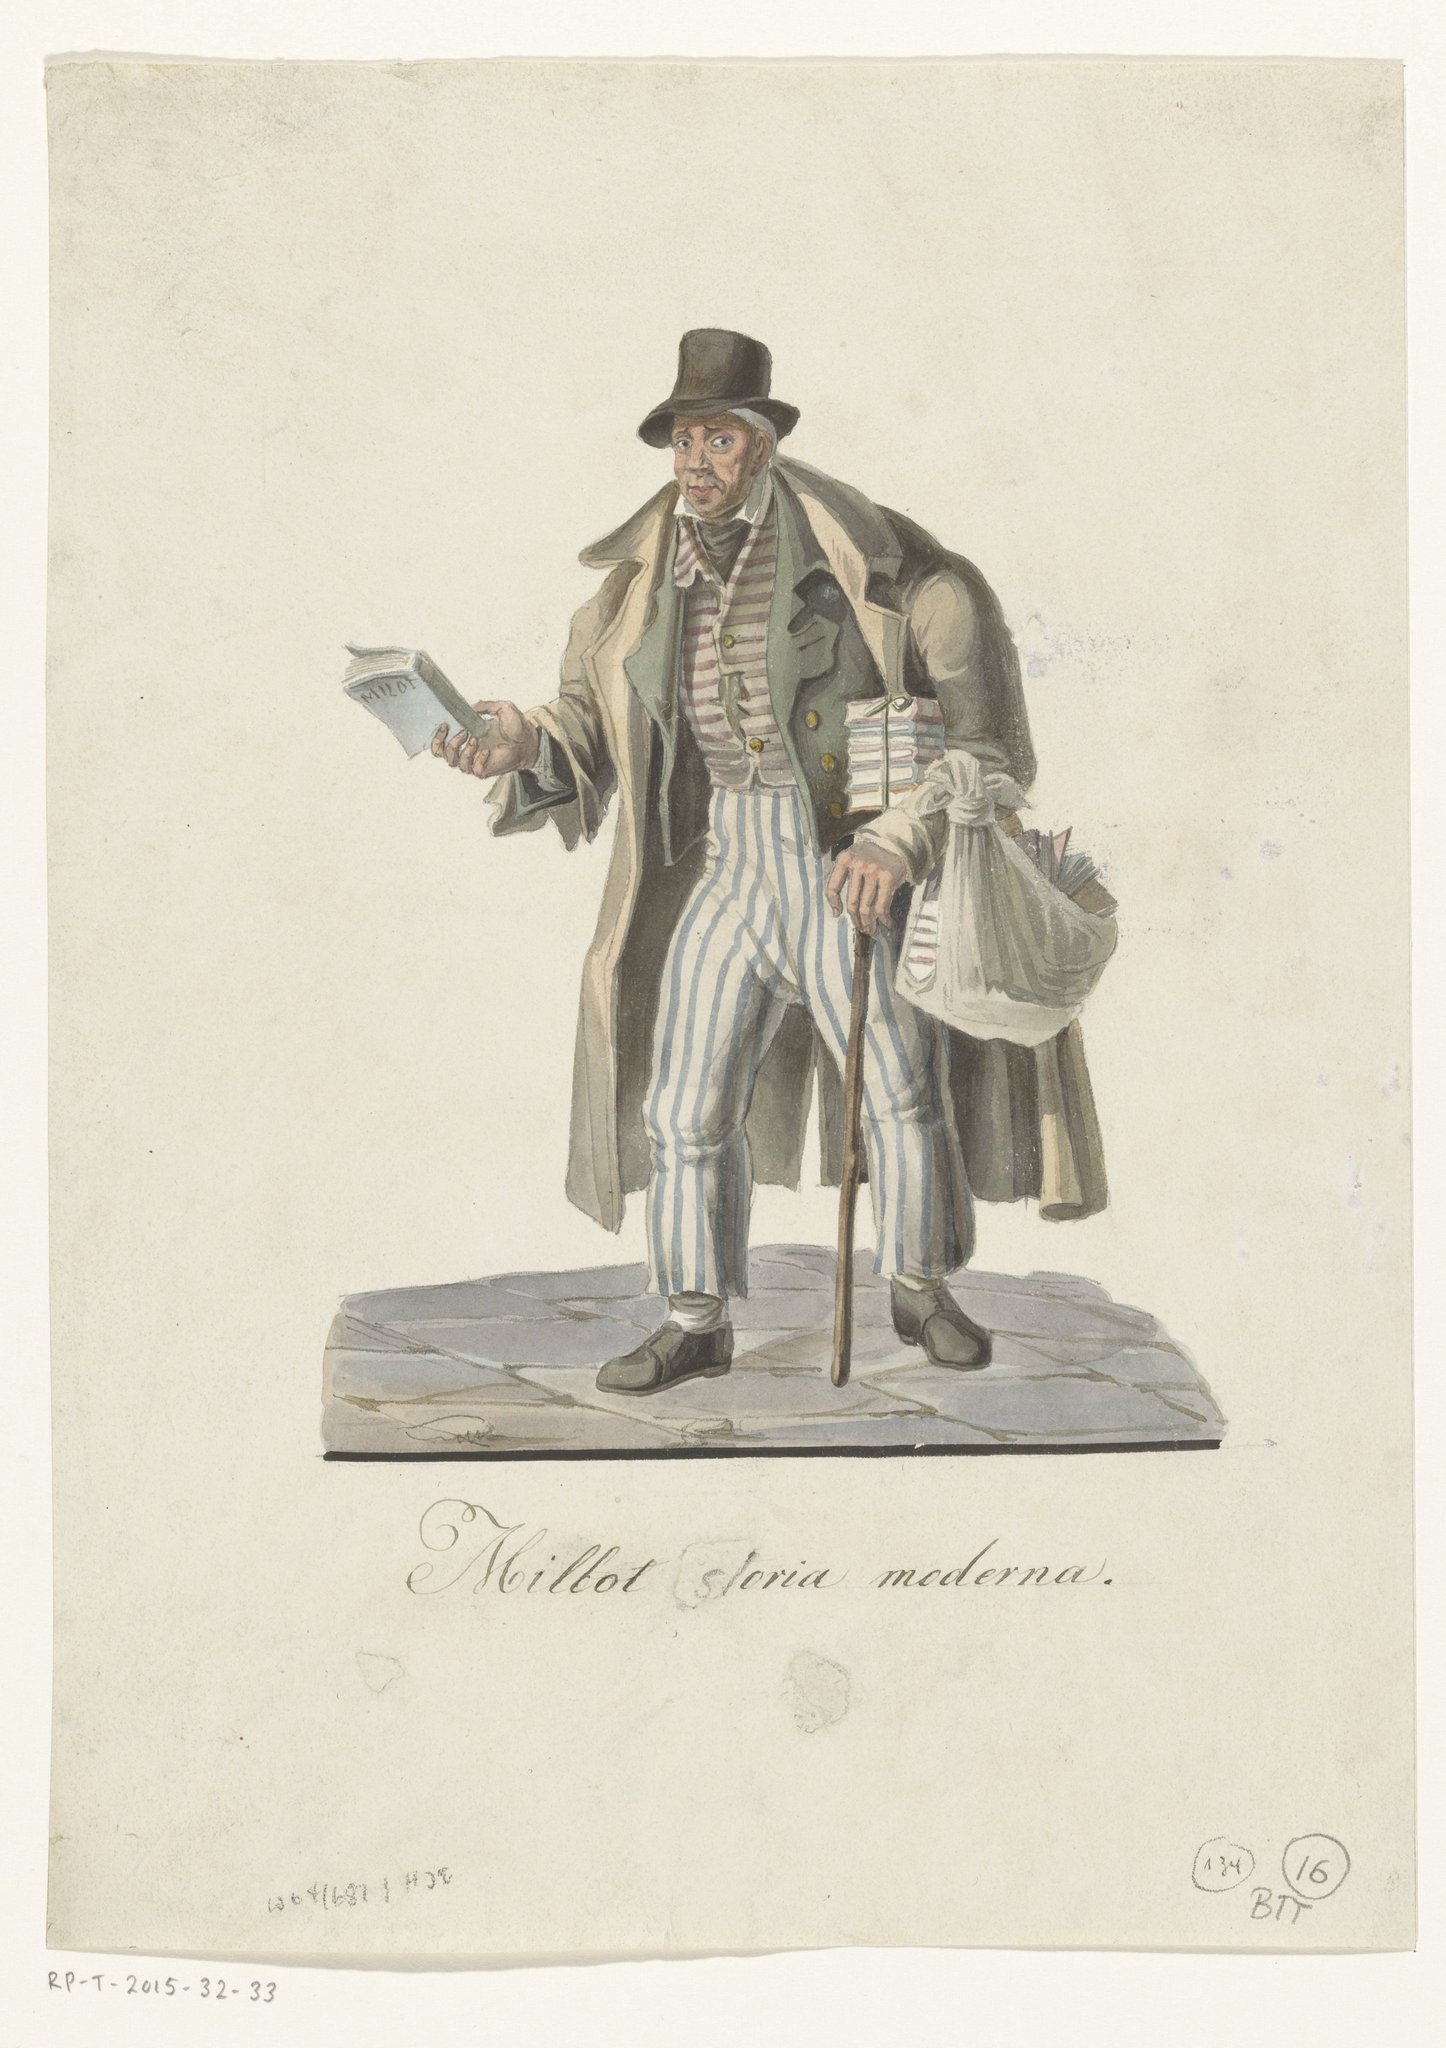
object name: print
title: Millot storia moderna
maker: Anonymous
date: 1800-1899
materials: ink, paper, watercolor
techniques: brush, pen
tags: book, book-shop, bookseller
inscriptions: collector's mark: Lugt 2228, collector's mark: Lugt 4779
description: Een man in een lange jas met een hoed op zijn hoofd, in zijn linkerhand een wandelstok. Onder zijn linkerarm heeft hij een stapel boeken geklemd, in een bundel aan zijn arm draagt hij nog meer boeken met zich mee. Met zijn rechterhand houdt hij een boek omhoog met de titel 'Millot'.